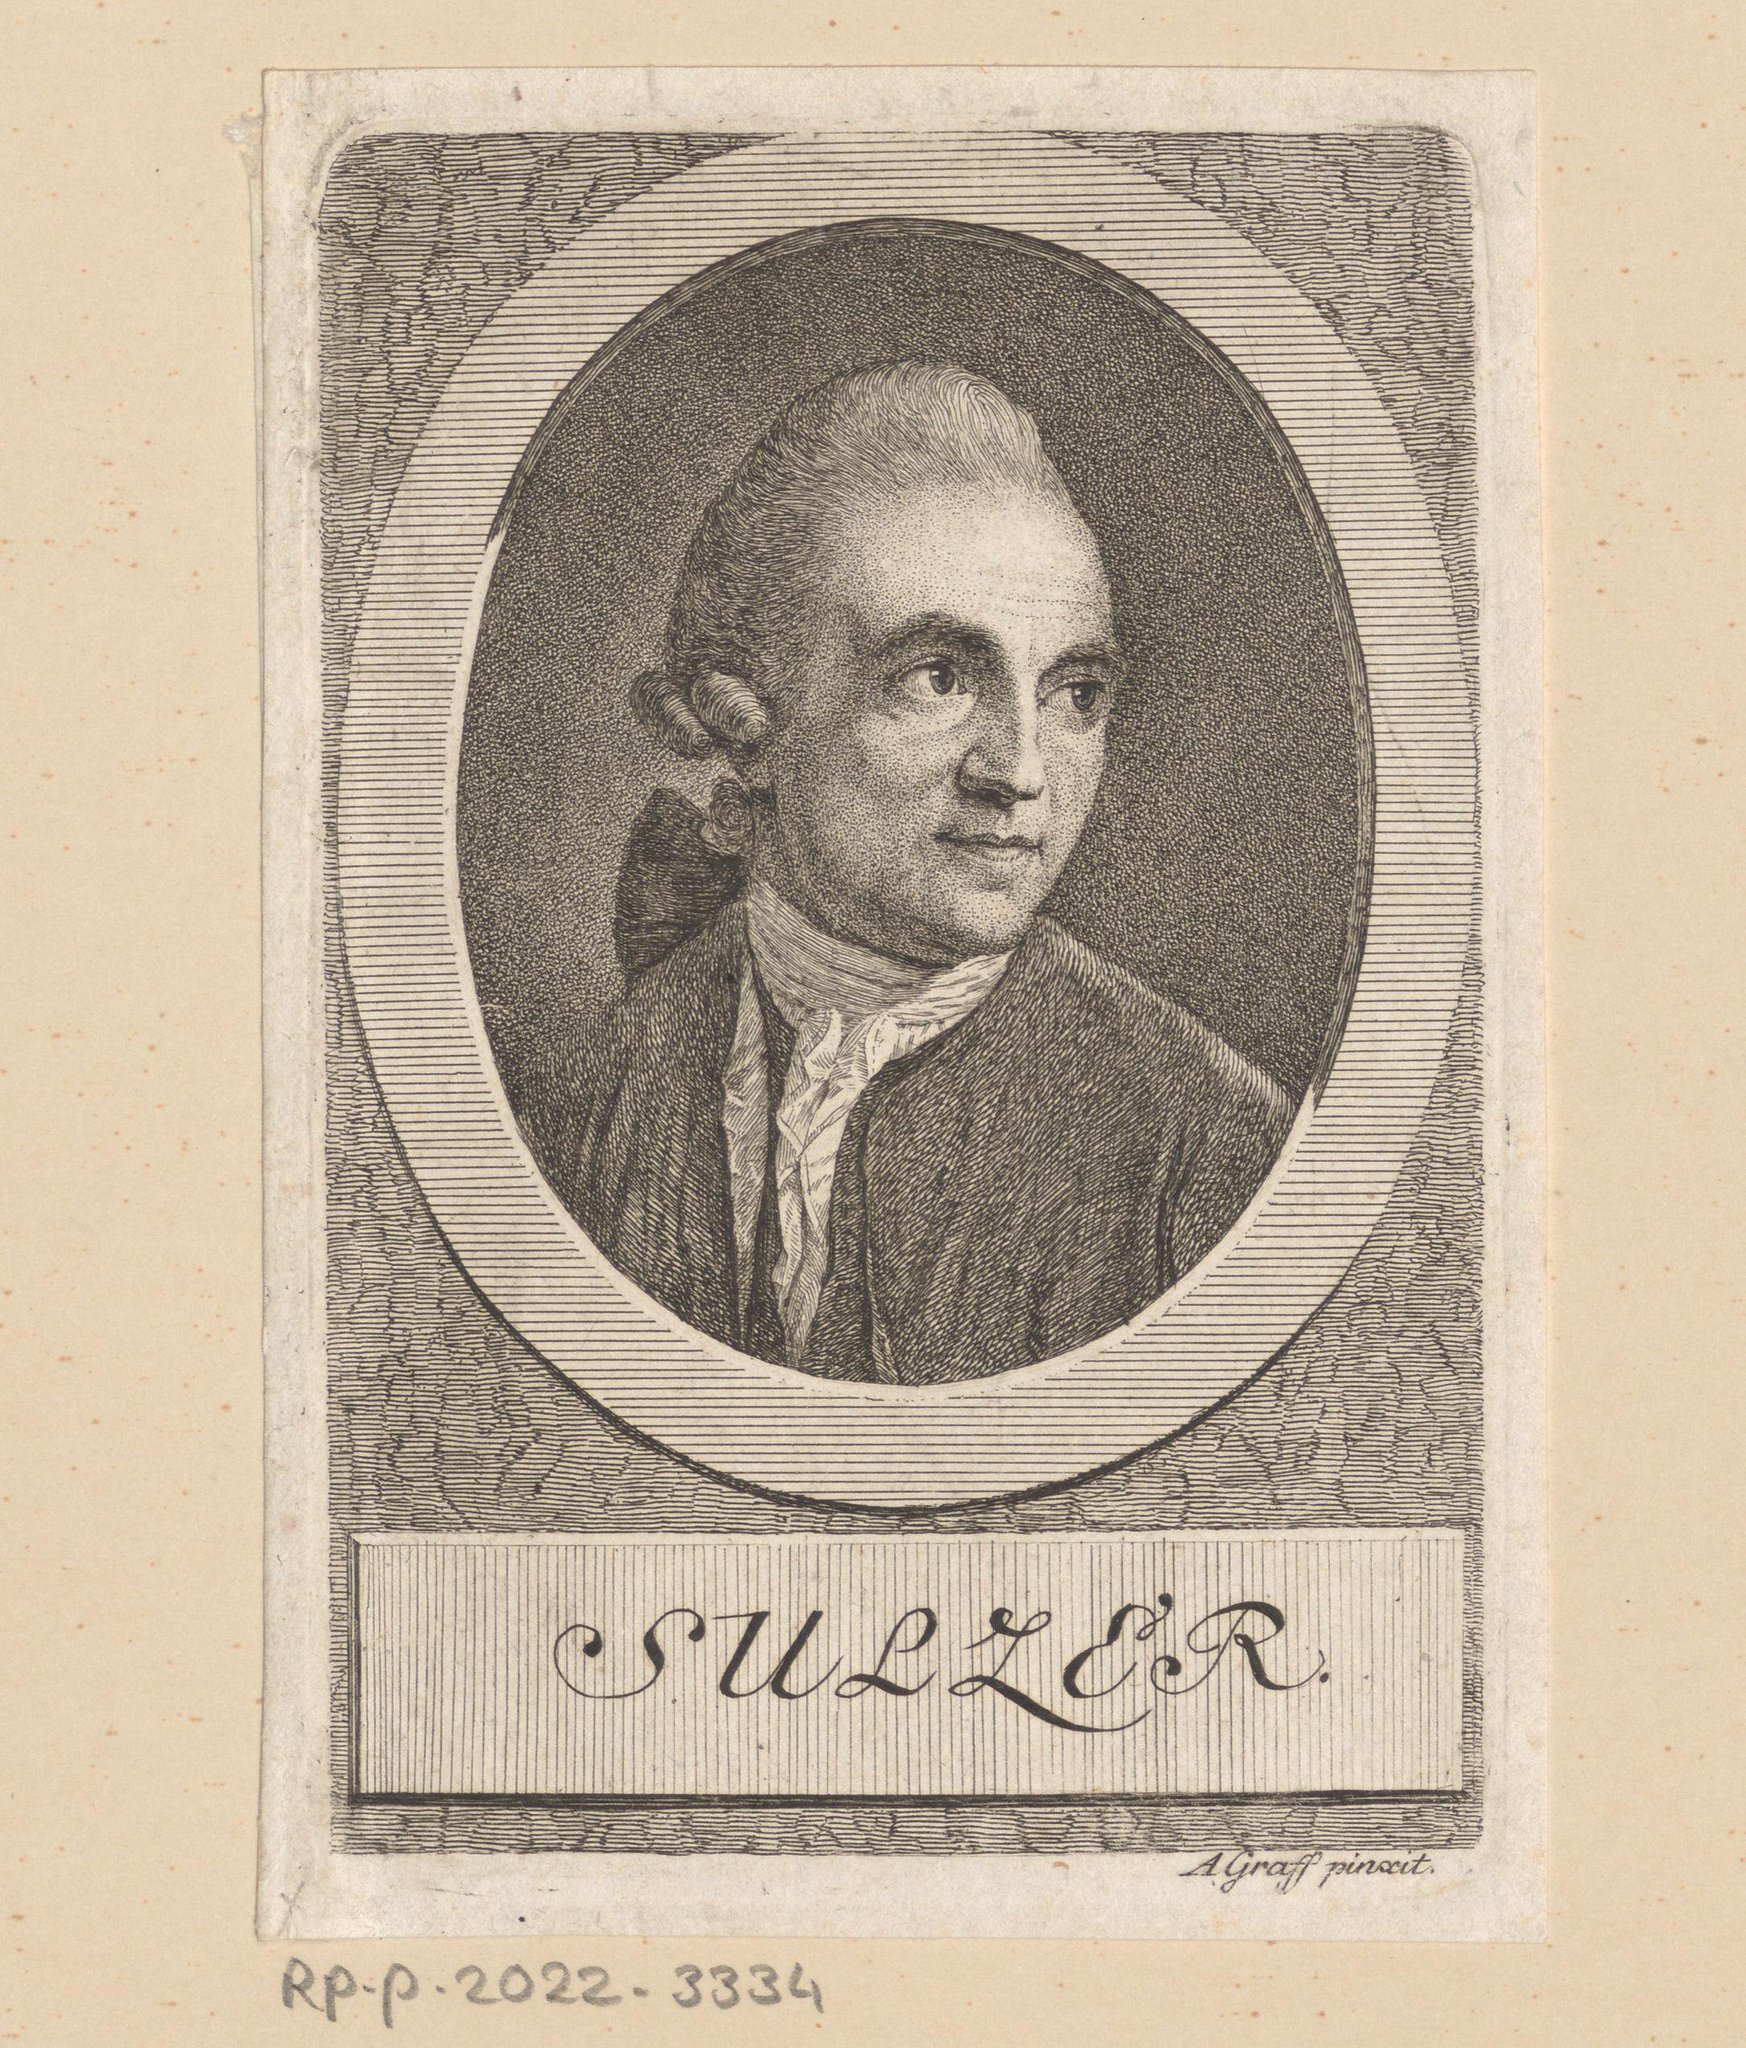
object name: print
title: Portret van Johann Georg Sulzer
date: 1750-1820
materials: paper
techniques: etching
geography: germany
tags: berlin, scholar, philosopher, historical persons